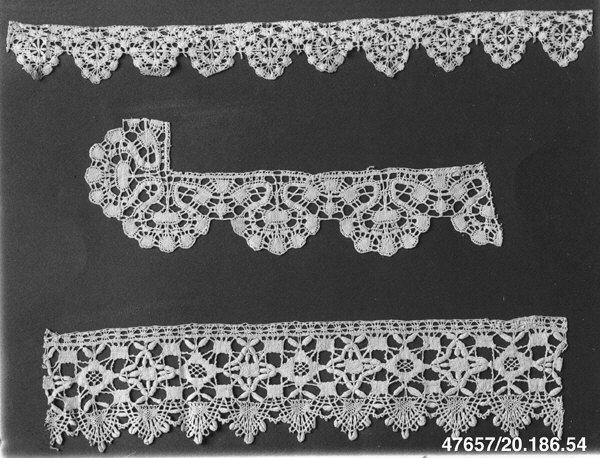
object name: edging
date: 1601-1700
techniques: lace